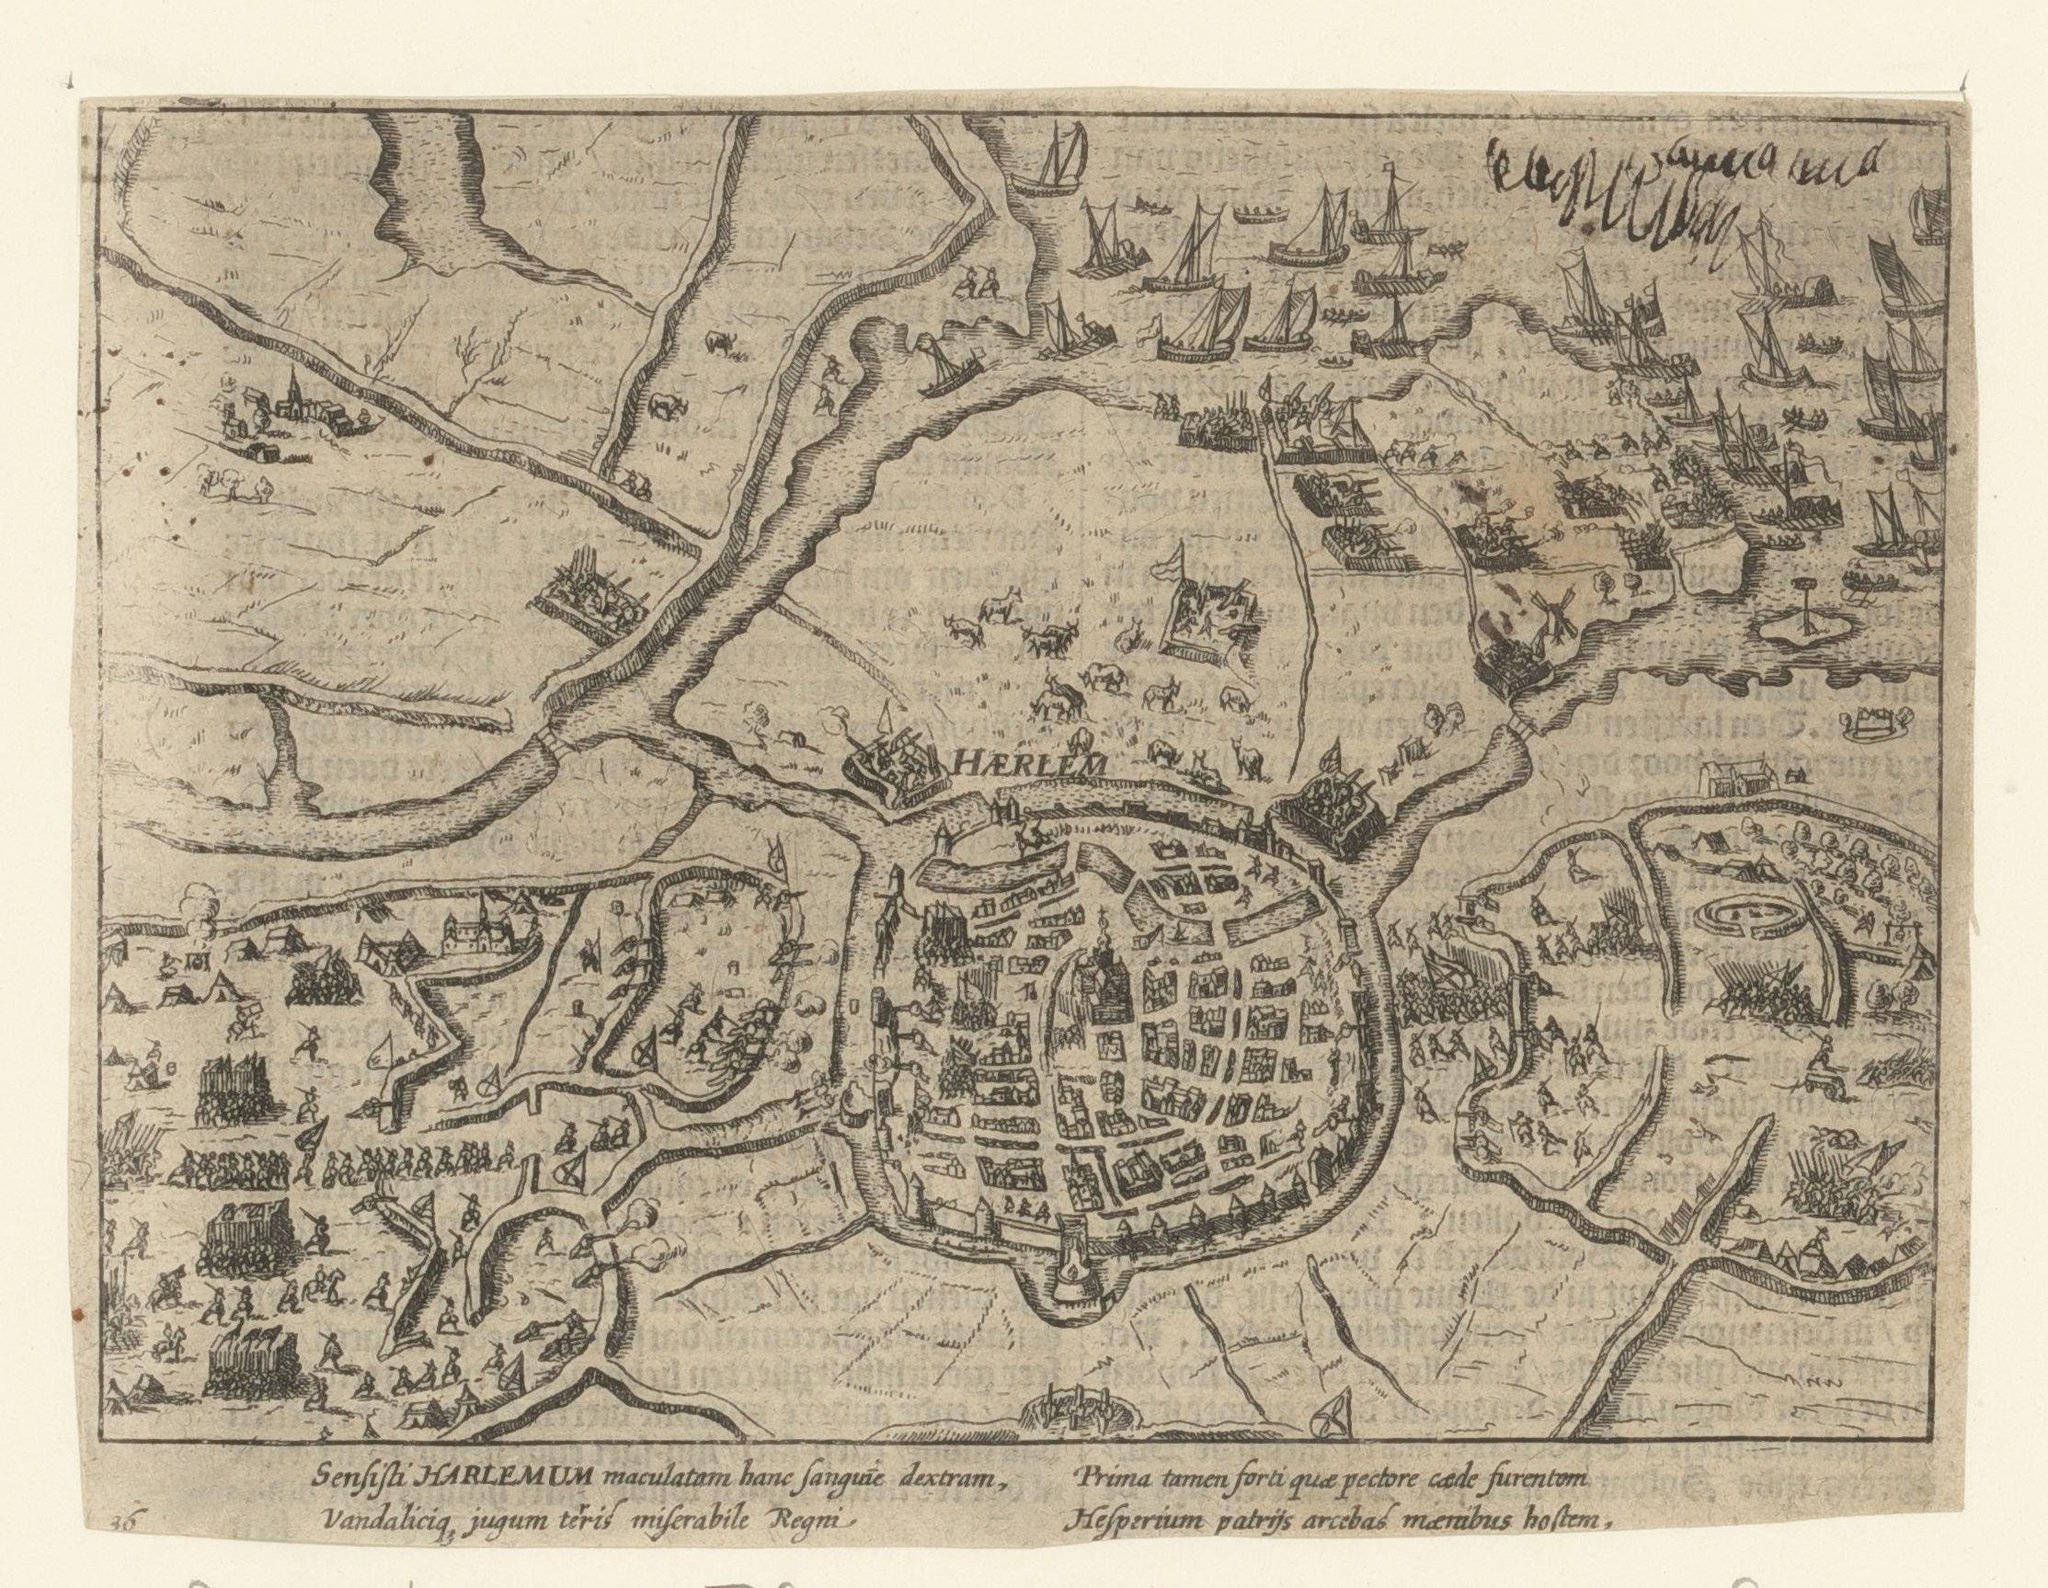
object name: book illustration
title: Beleg van Haarlem, 1572-1573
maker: Anonymous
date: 1613-1615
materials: ink, paper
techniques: etching, pen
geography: northern netherlands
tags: maps of separate countries or regions, siege, position war, maps of cities, haarlem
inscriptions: collector's mark, collector's mark: Lugt 1641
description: Kaart van de stad Haarlem en het omringend gebied met de legerplaatsen van de belegerende Spaanse troepen van Don Frederik. Boven schepen van Alva en de prins van Oranje op het water van het Haarlemmermeer. Het beleg ving aan op 11 december 1572. Met onderschrift van 4 regels in het Latijn. Genummerd: 36. Bedrukt op achterzijde met tekst in het Nederlands. Onderwerpsrubrieken binnen de Atlas Zeden en Gewoonten: Krijgswezen; prenten van Baudart. 80j. oorlog.